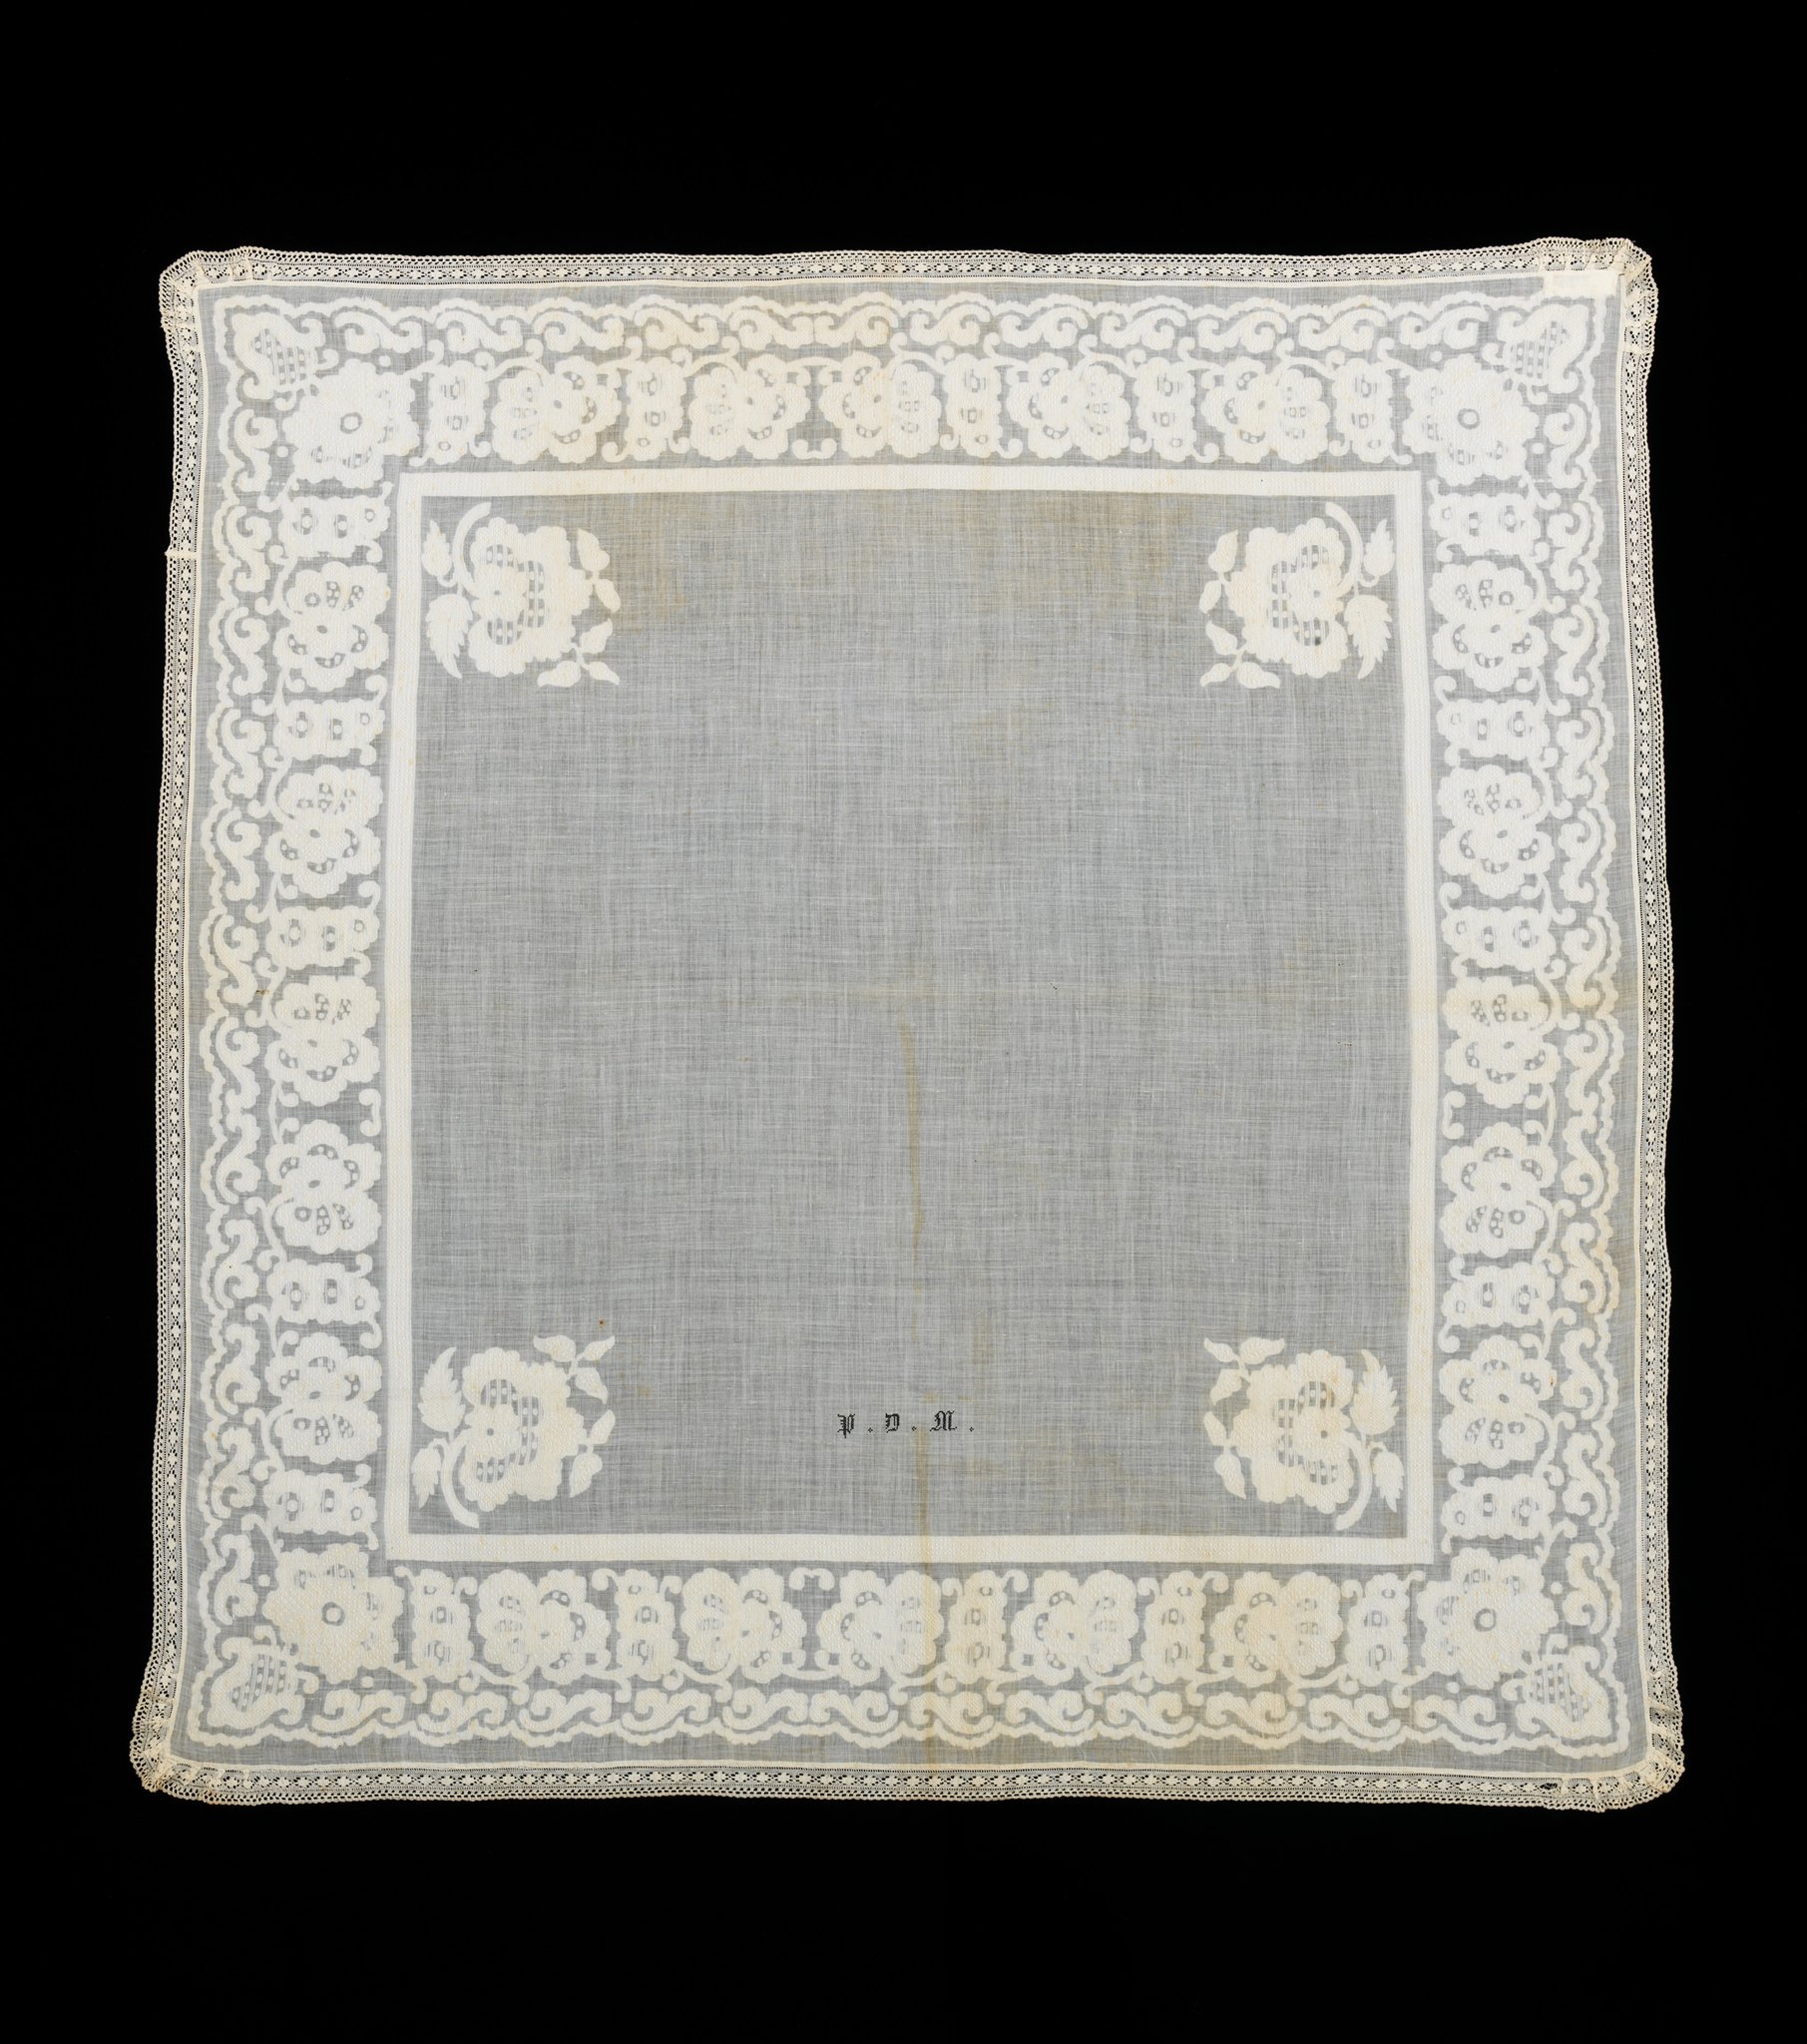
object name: headcloth kerchief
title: Kerchief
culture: philippine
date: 1867-1900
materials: cotton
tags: flowers